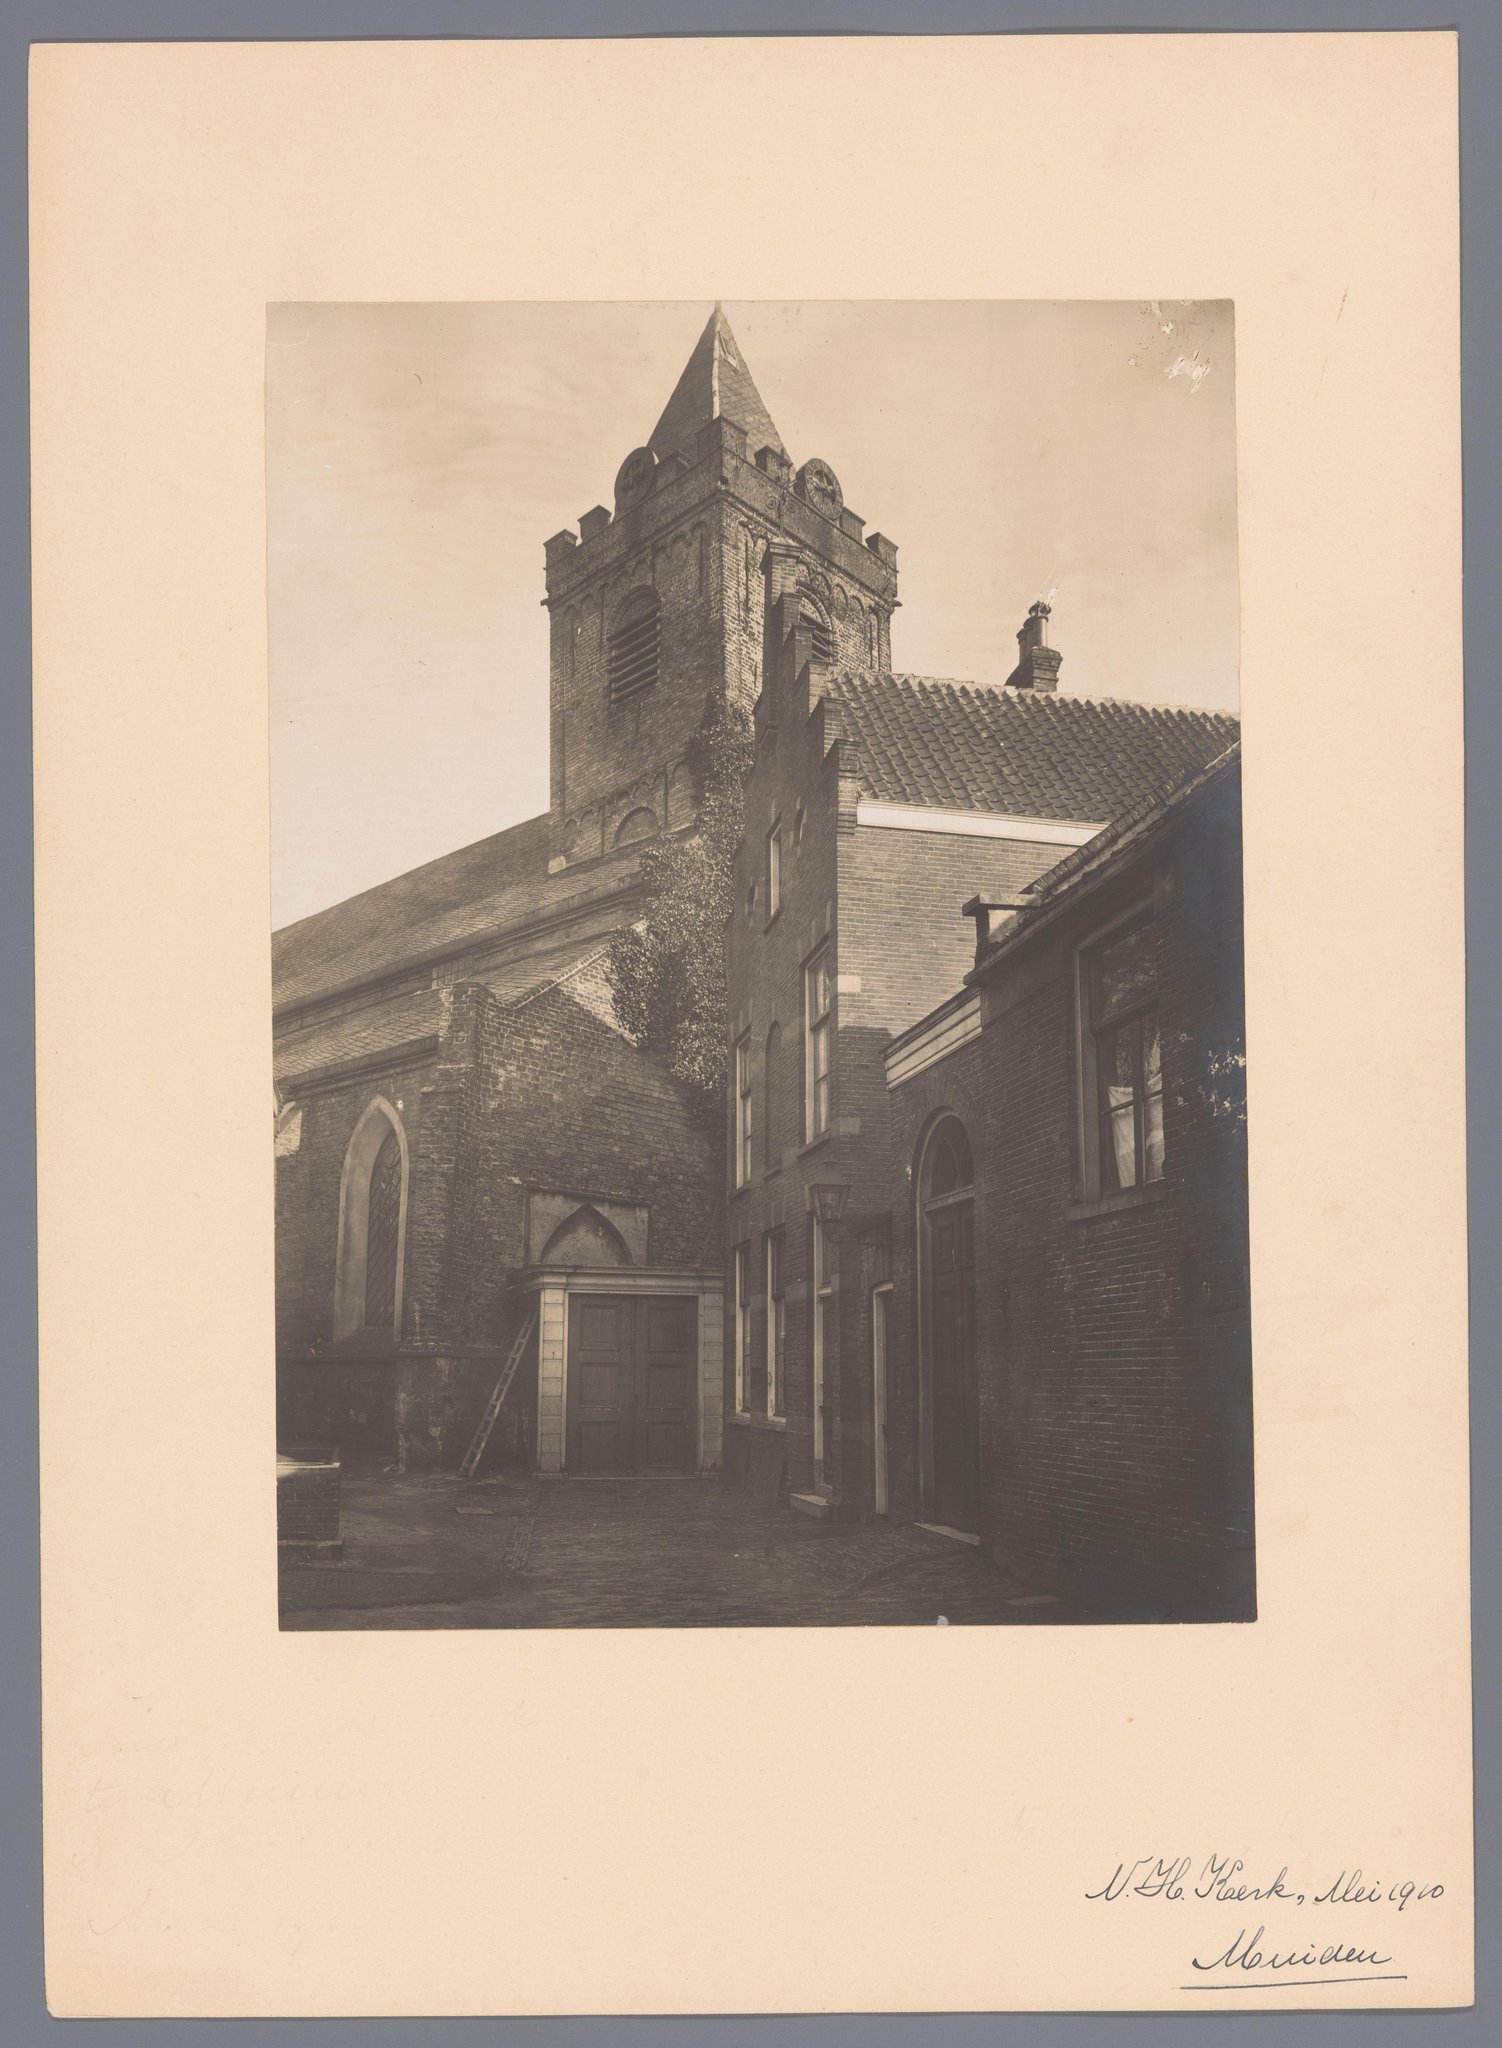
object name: photograph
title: Gezicht op de Grote Kerk te Muiden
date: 1910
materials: cardboard, photographic support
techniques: gelatin silver print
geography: muiden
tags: church (exterior)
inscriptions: annotation: ‘N.H. Kerk, Mei 1910/ Muiden’, annotation: ‘H. van Thull van Serooskerken/ Ca. 1575 - 1627’